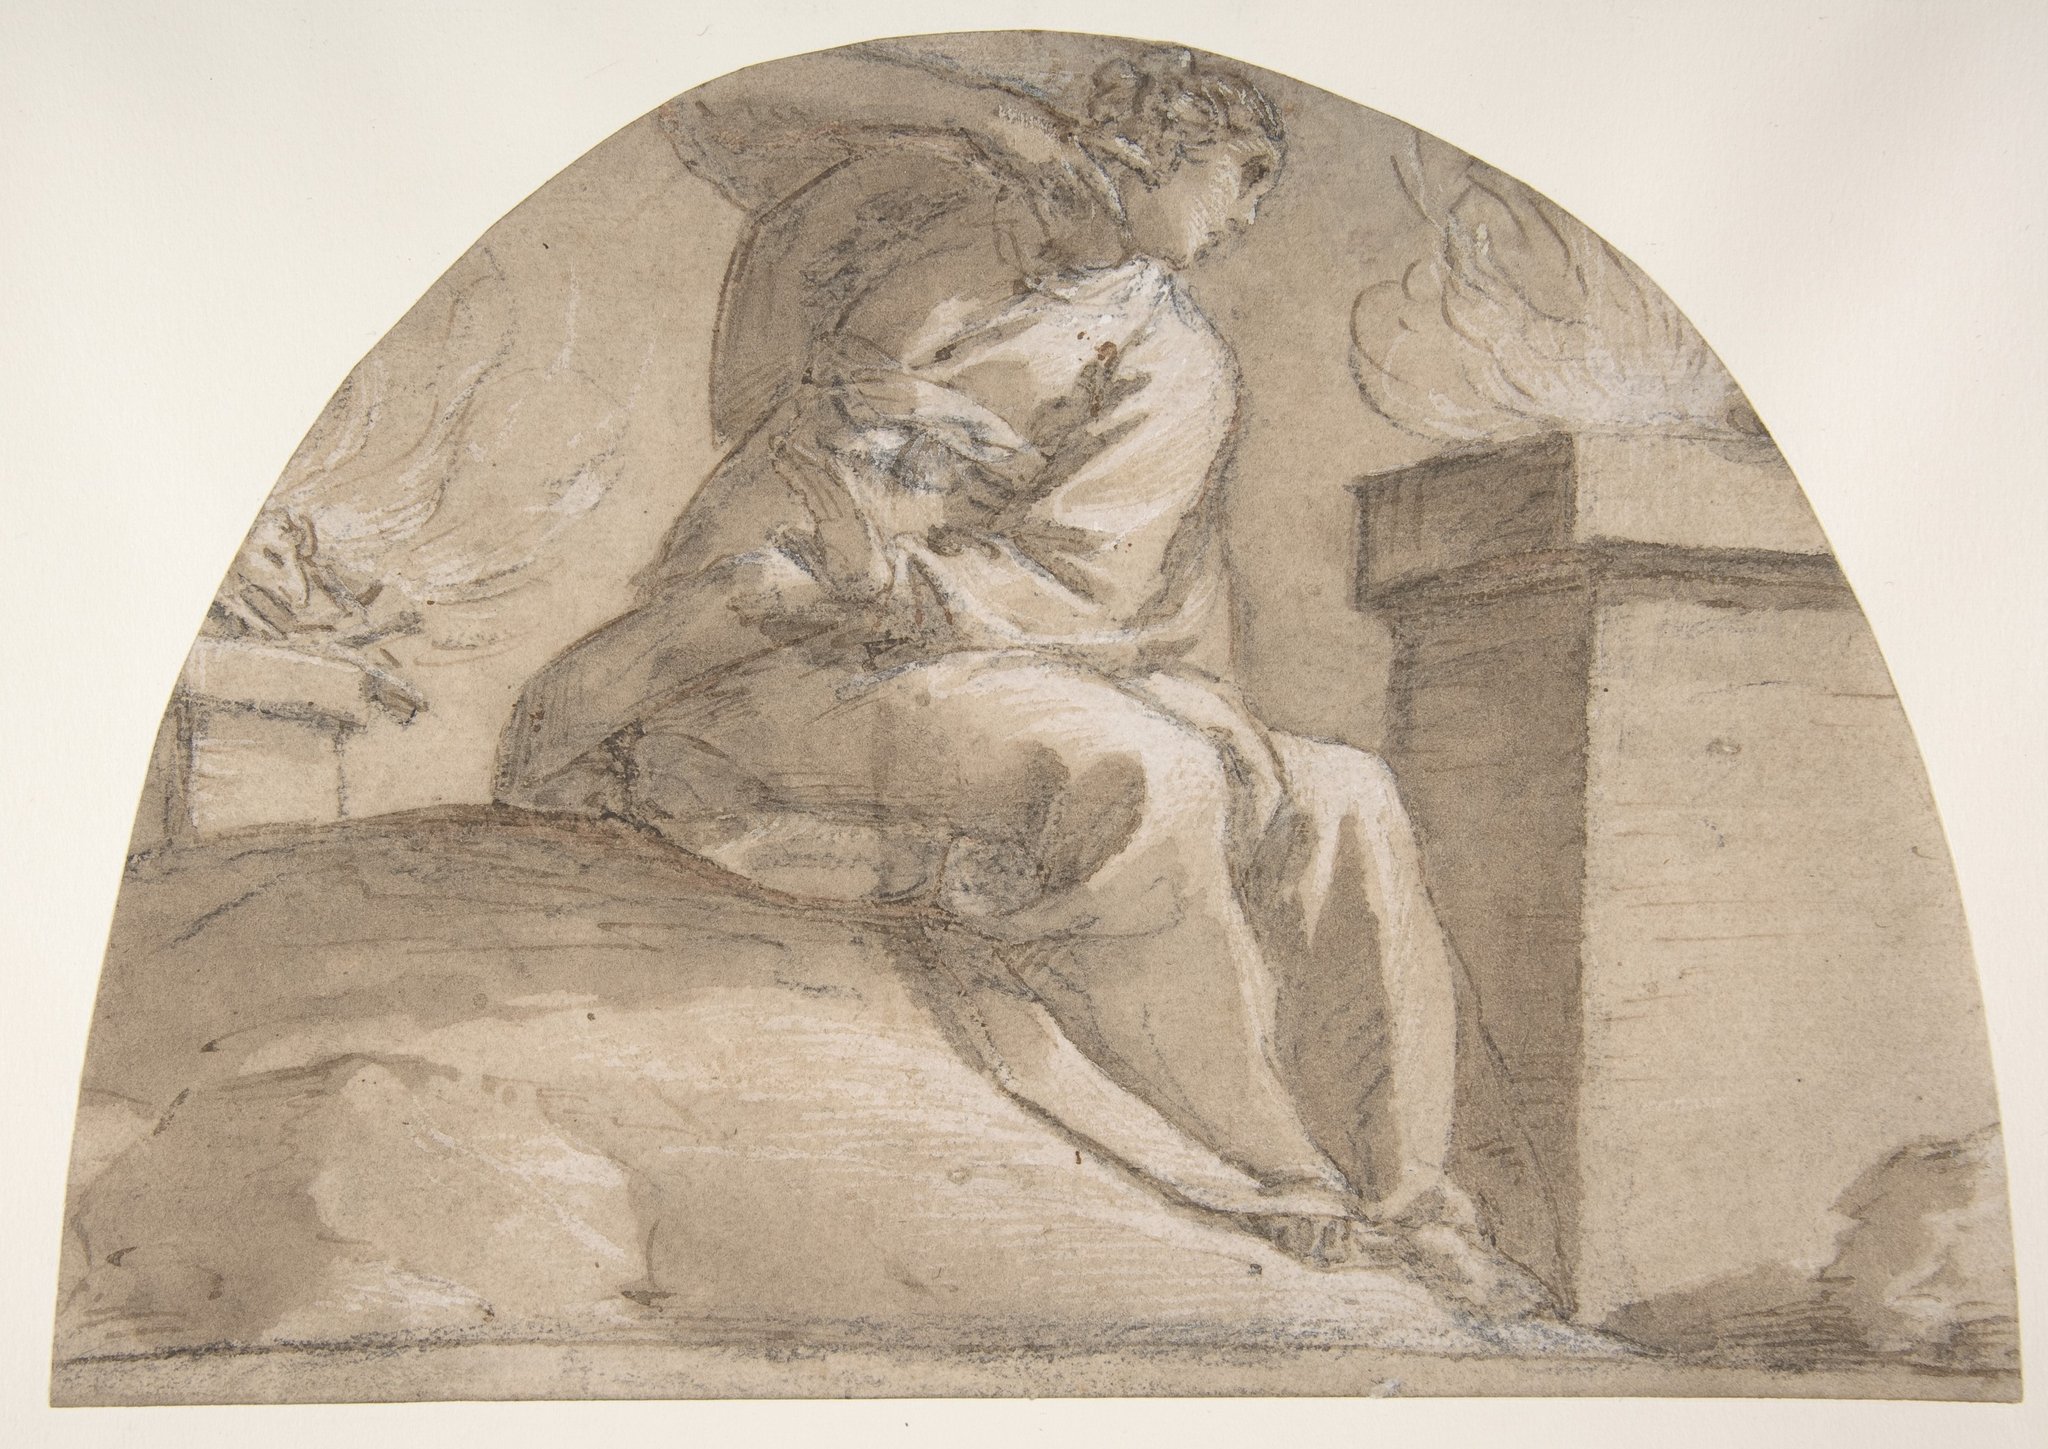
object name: drawing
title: Seated Allegorical Female Figure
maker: morazzone (pier francesco mazzucchelli)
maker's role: artist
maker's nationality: italian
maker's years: 1573-1626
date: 1573-1626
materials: chalk, ink, paper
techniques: highlighting, pen, wash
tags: women